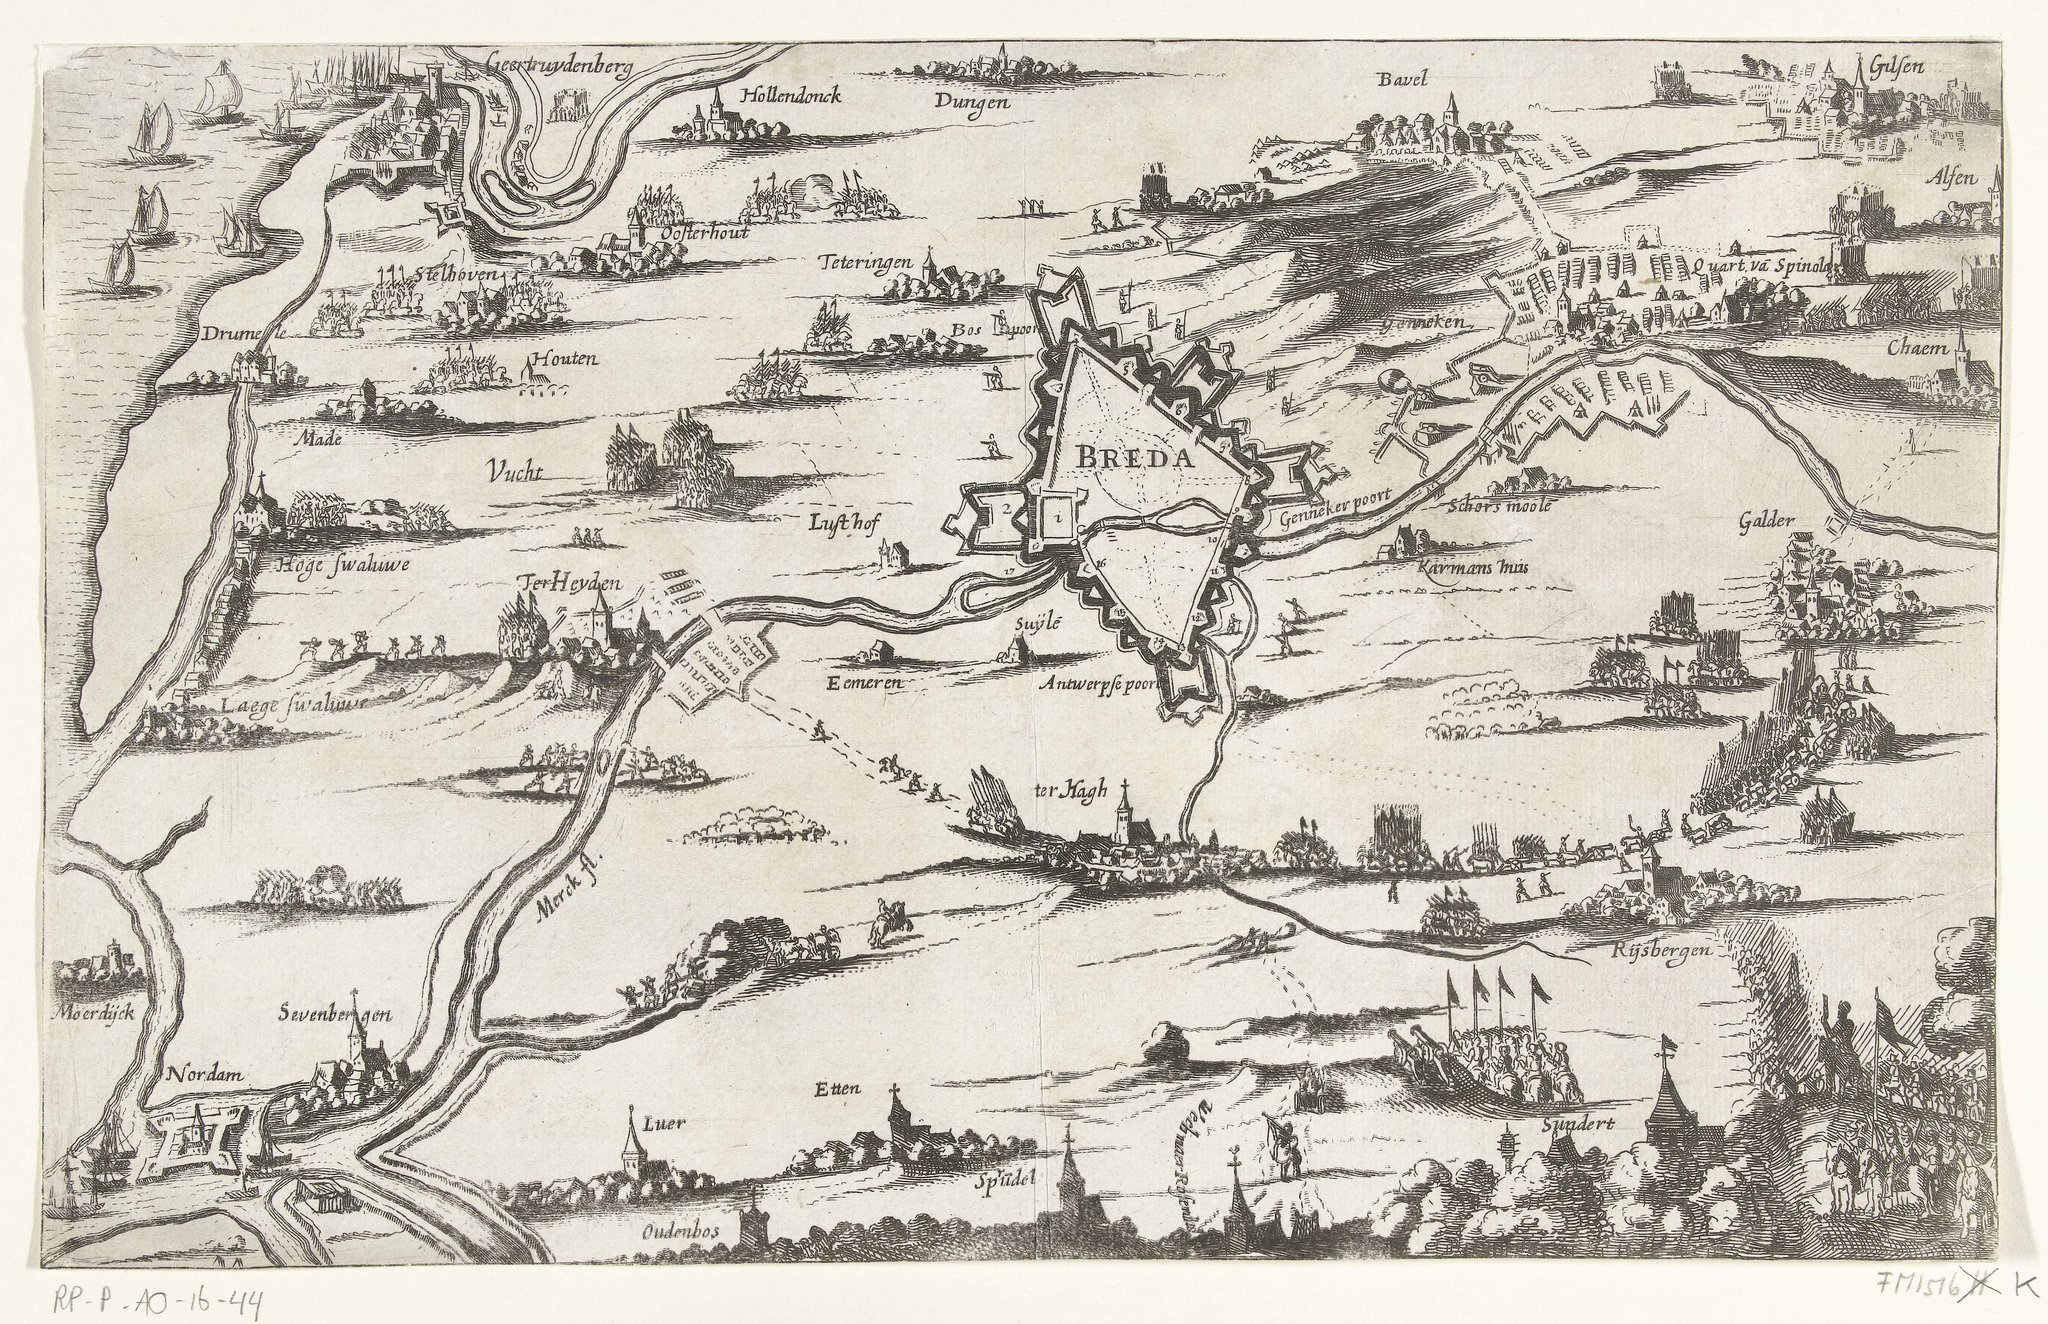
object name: print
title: Beleg van Breda, 1624-1625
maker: Anonymous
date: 1624-1625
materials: paper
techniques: etching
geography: low countries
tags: siege, position war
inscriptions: collector's mark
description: Kaart met het beleg van Breda door het Spaanse leger onder Spinola, 27 augustus 1624 tot 5 juni 1625. Met de versterkingen om de stad, met omliggende land en optrekkende Spaanse legers vanuit het legerkamop te Ginneken. Opschriften in de voorstelling in het Nederlands.